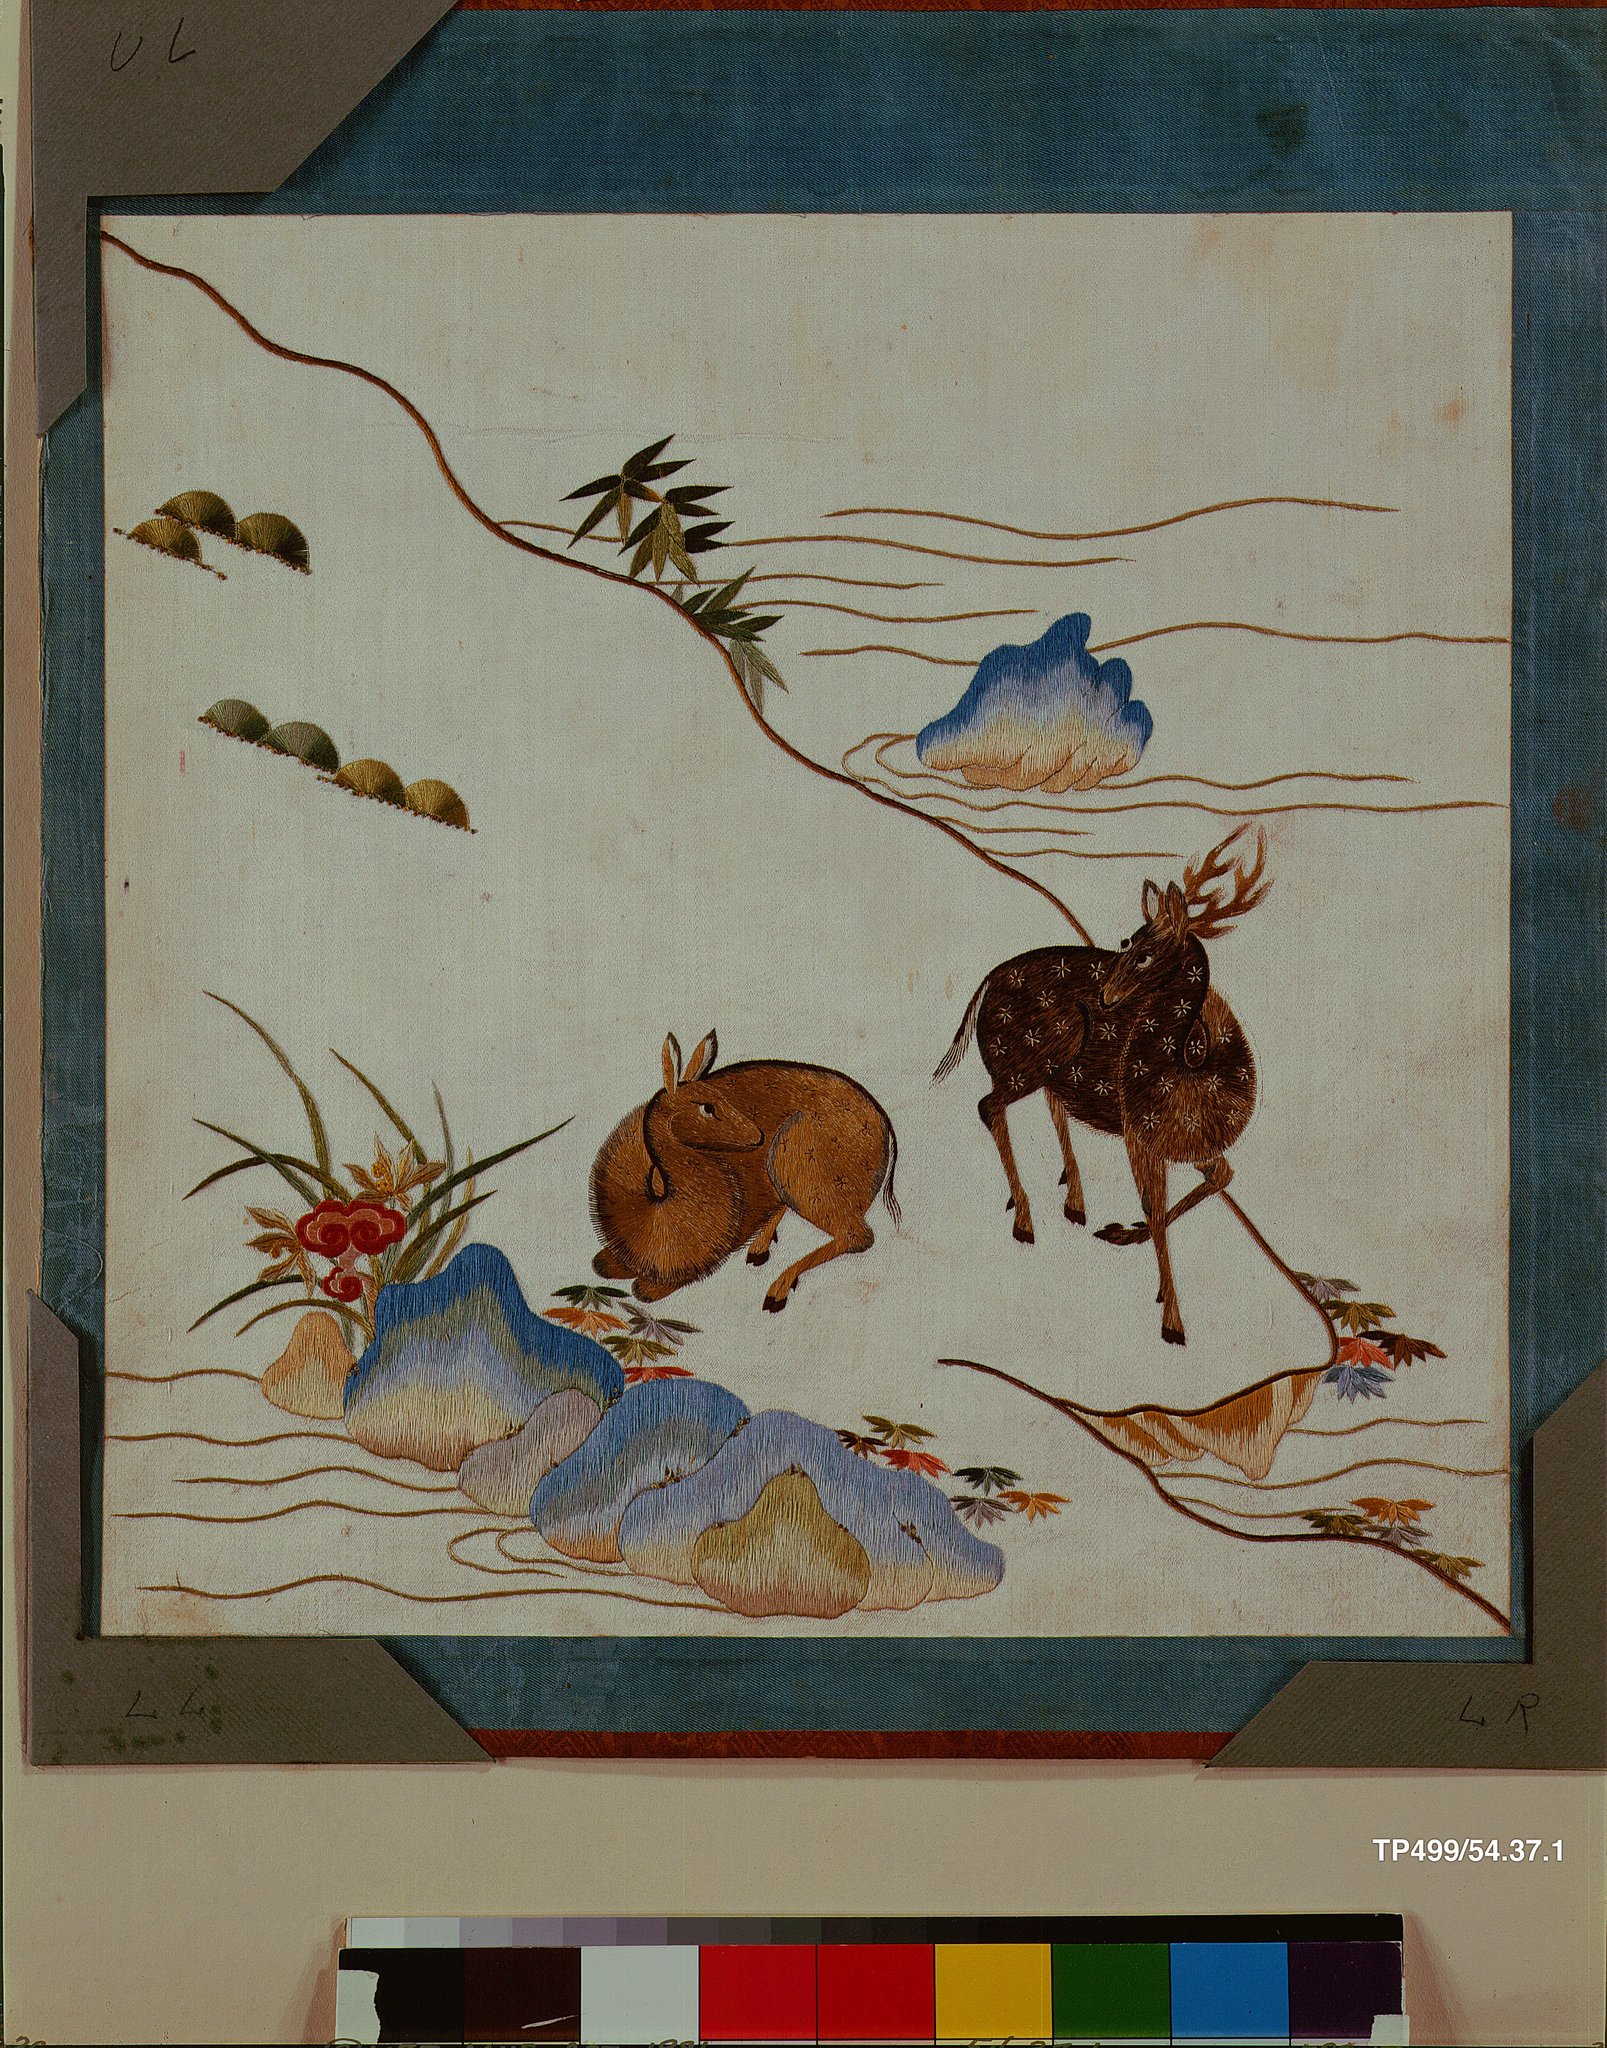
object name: album leaf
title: Landscape with Pair of Spotted Deer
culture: chinese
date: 1734-1766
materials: silk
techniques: embroidery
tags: deer,flowers,landscapes,plants